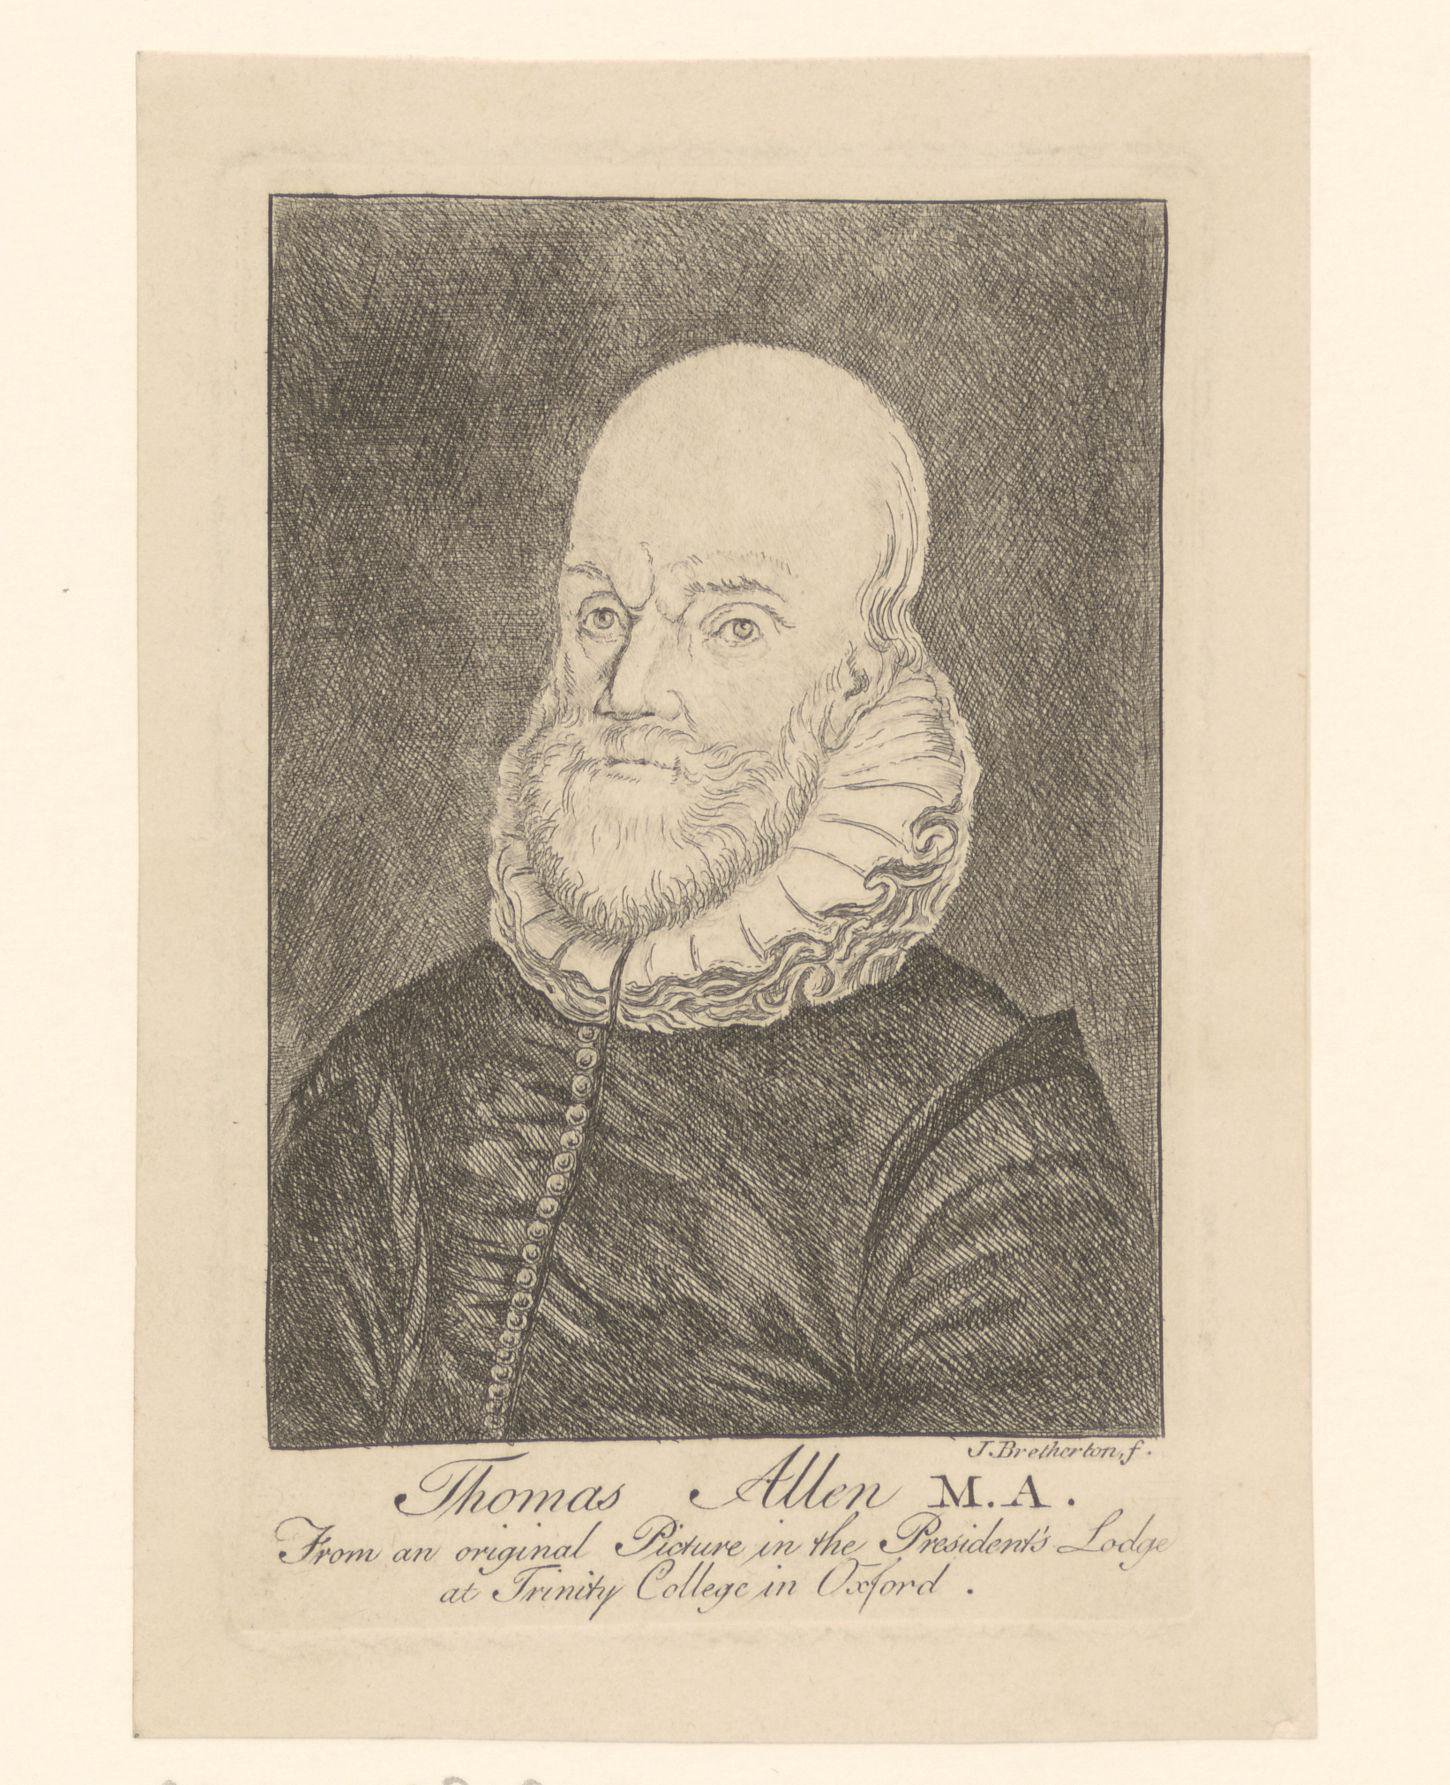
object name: print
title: Portret van Thomas Allen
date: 1760-1781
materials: paper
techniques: etching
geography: england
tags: scholar, philosopher, historical persons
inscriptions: collector's mark: Lugt 2228